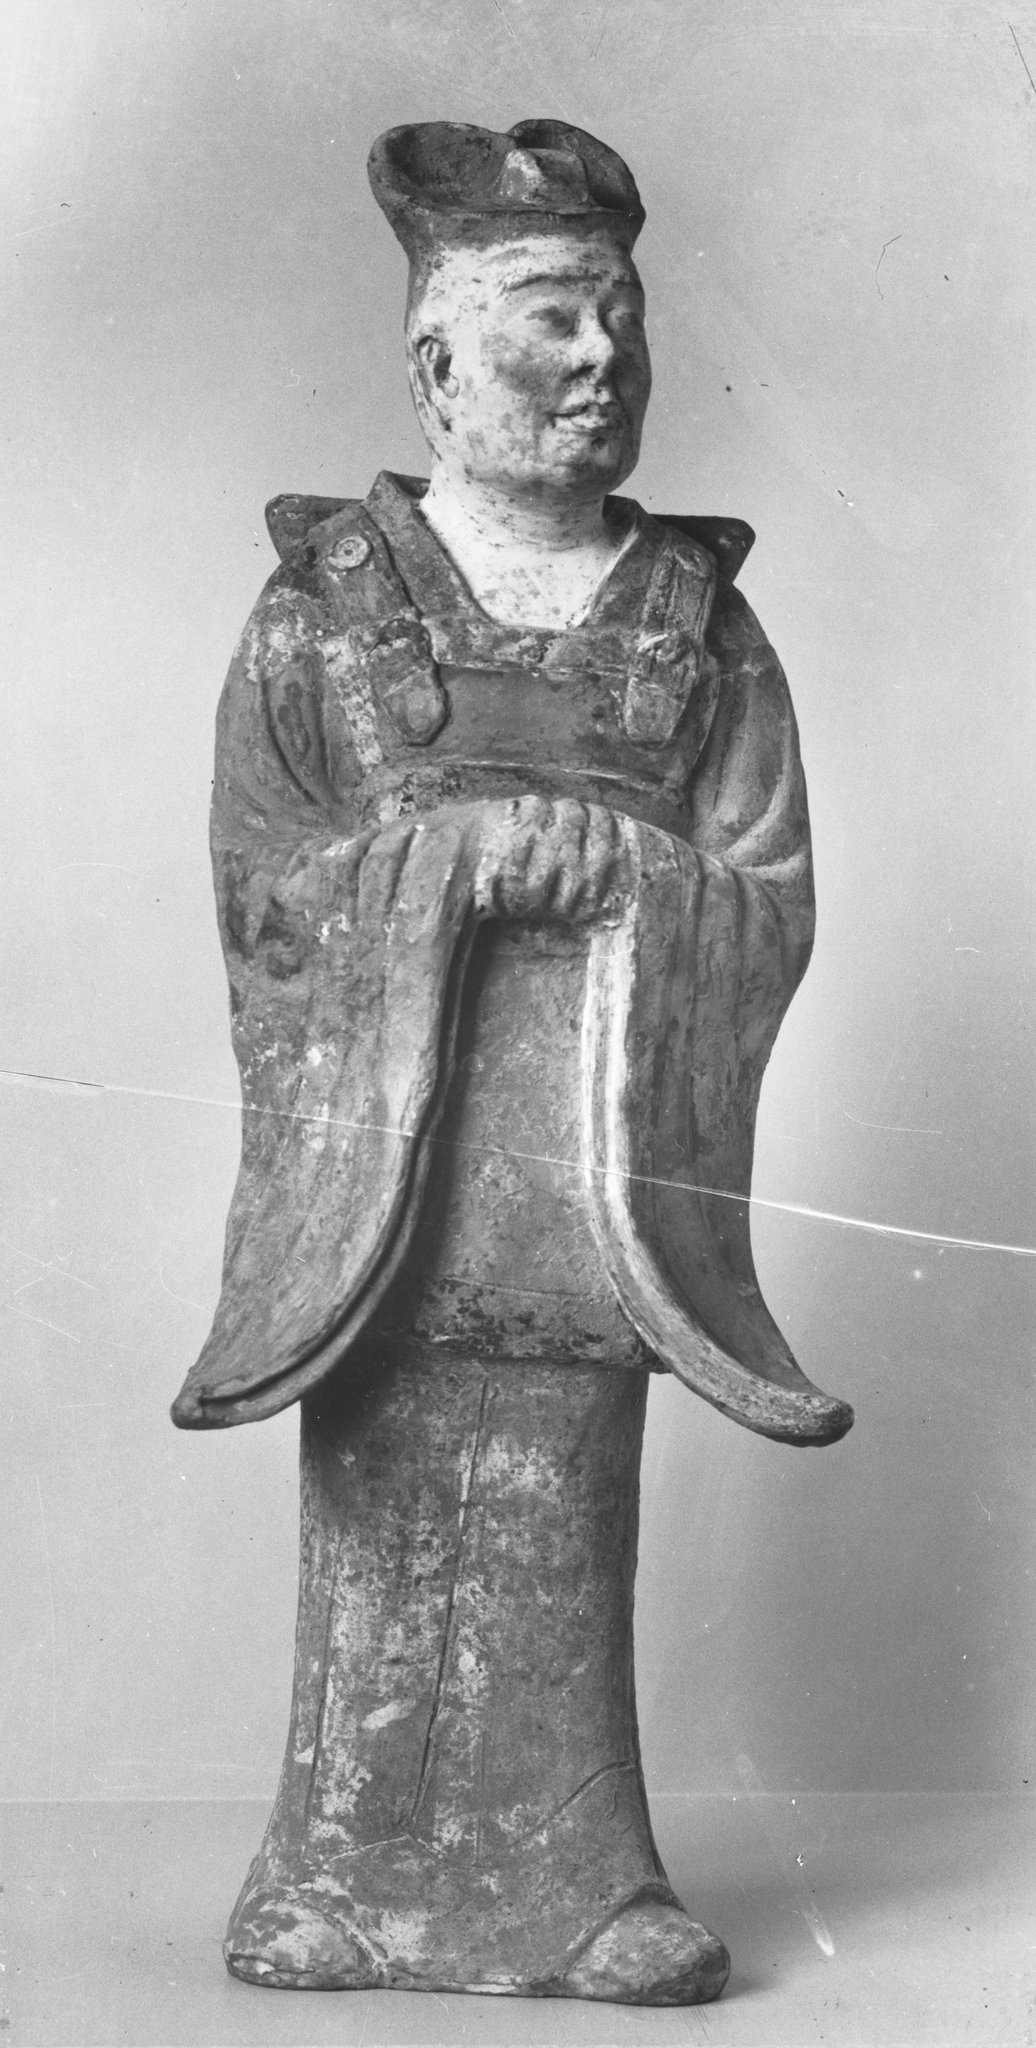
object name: figure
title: Civil official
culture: chinese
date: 501-600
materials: earthenware, pigment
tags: men